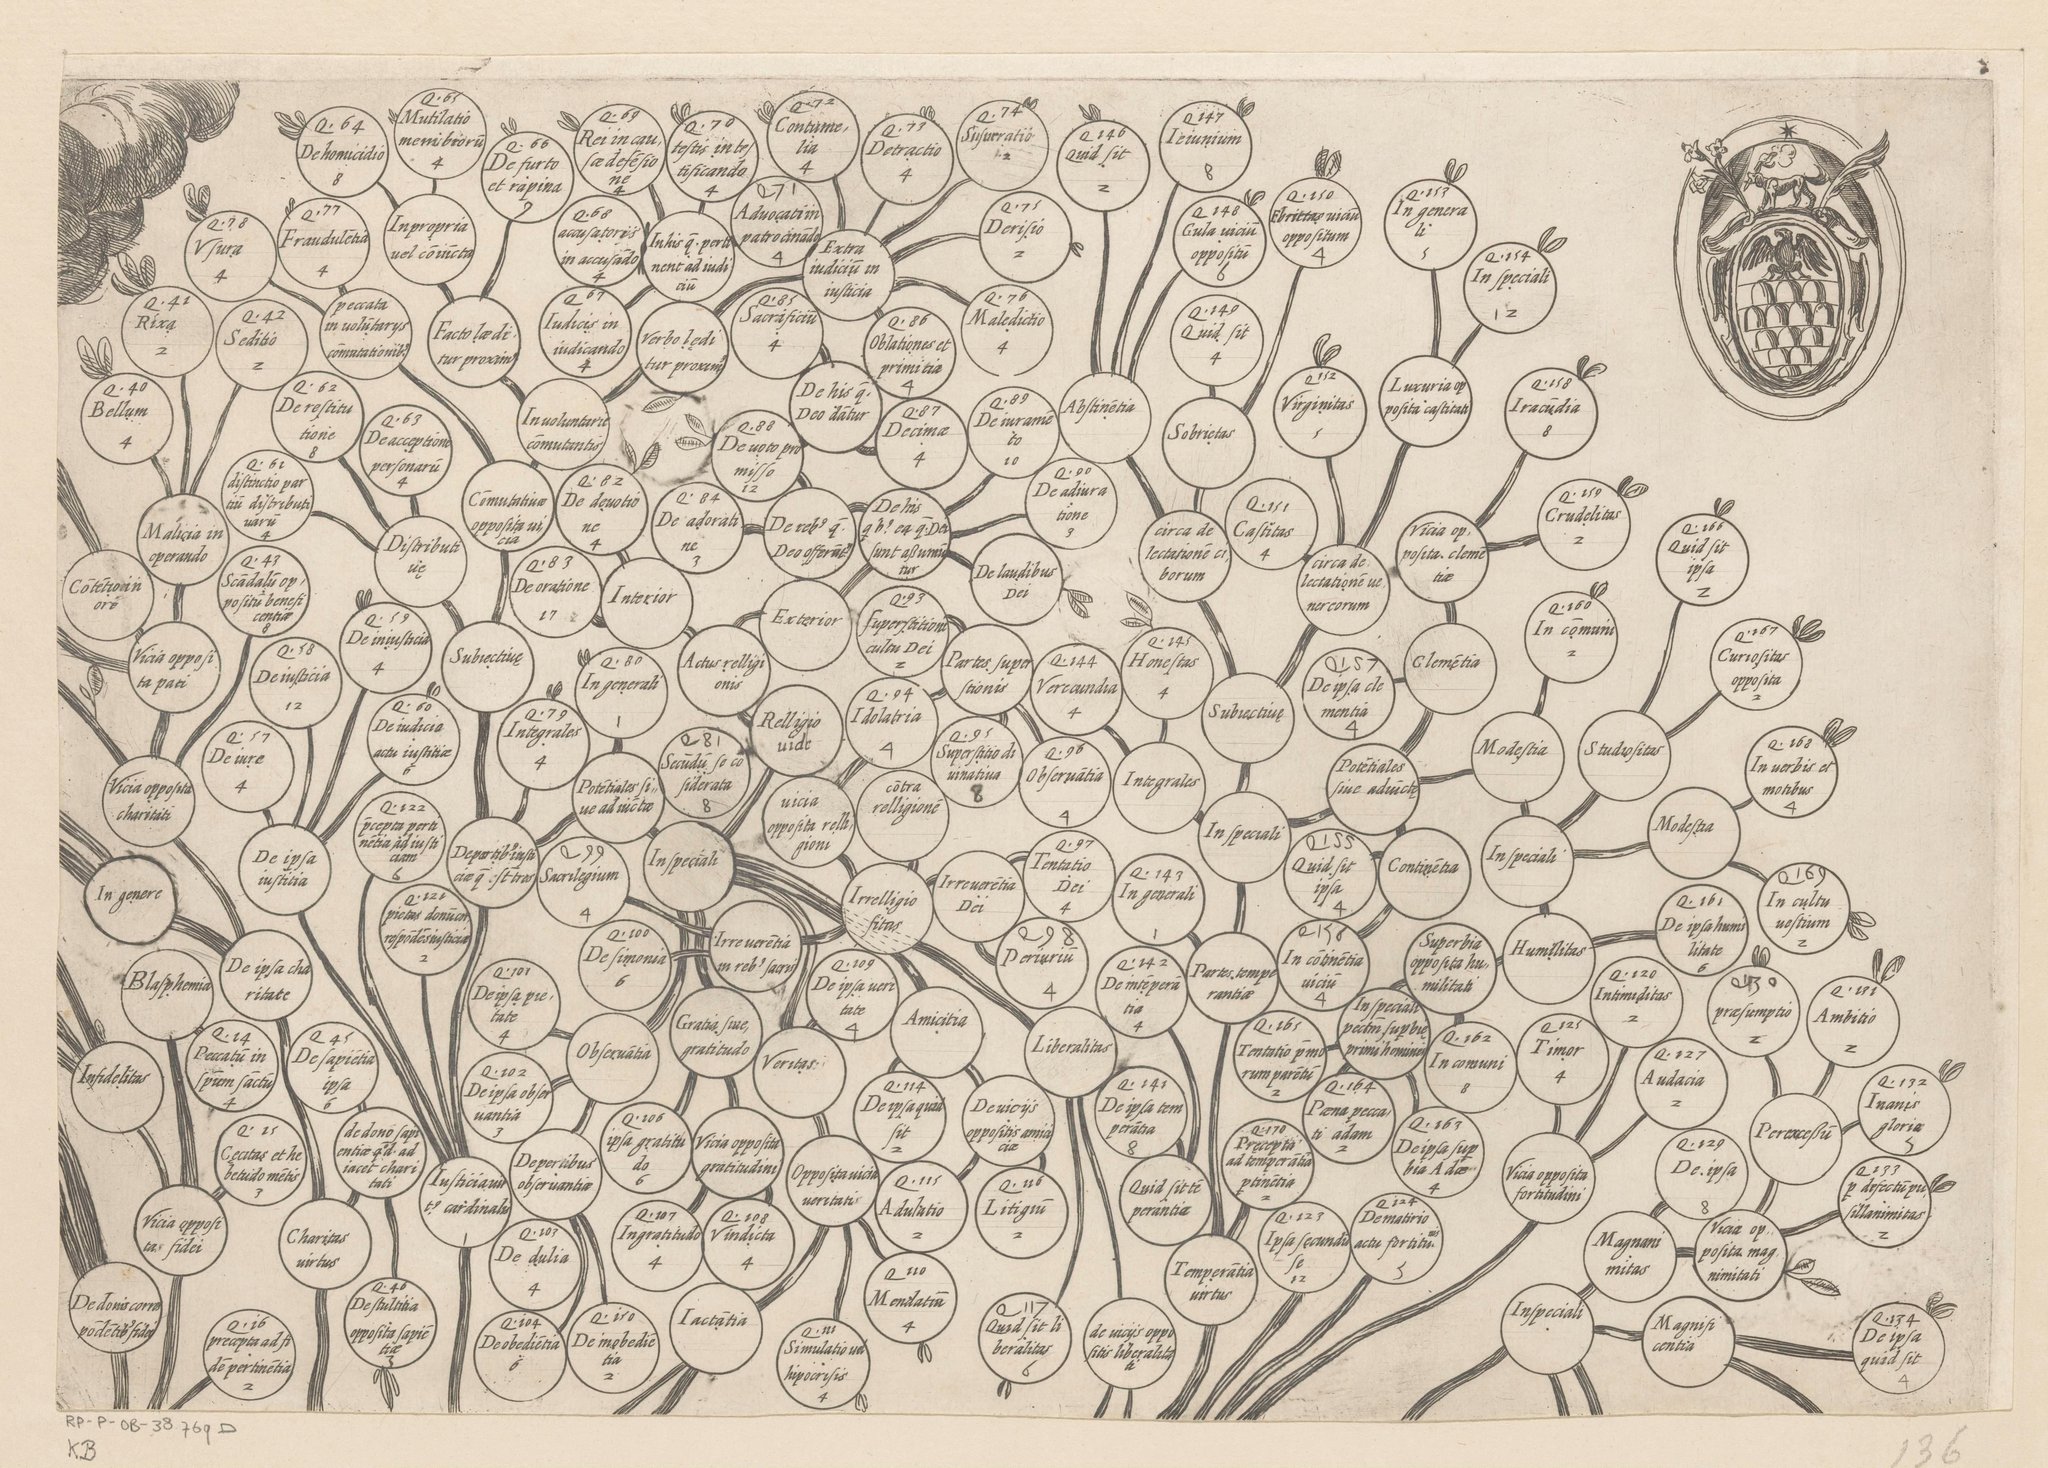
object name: print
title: Boom met Thomas van Aquino (deel rechtsboven)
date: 1590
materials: paper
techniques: etching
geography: rome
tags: thomas van aquino, christ crucified on a tree or on a vine, christian doctrine, the dominican theologian, 'angelic doctor' thomas of aquino; possible attributes: book, (chain with) sun, dove, girdle of chastity, lily, model of church, monstrance (or chalice), mitre (under feet), star (on breast)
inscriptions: collector's mark: Lugt 240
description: De filosoof en theoloog Thomas van Aquino ligt onderaan een boom. Op de stam van de boom de gekruisigde Christus. De vertakkingen van de boom representeren de drie delen van Aquino's 'Summa Theologiae'. Bovenaan in het midden God de Vader en de Heilige Geest als duif. Linksboven en rechtsboven een wapenschild.